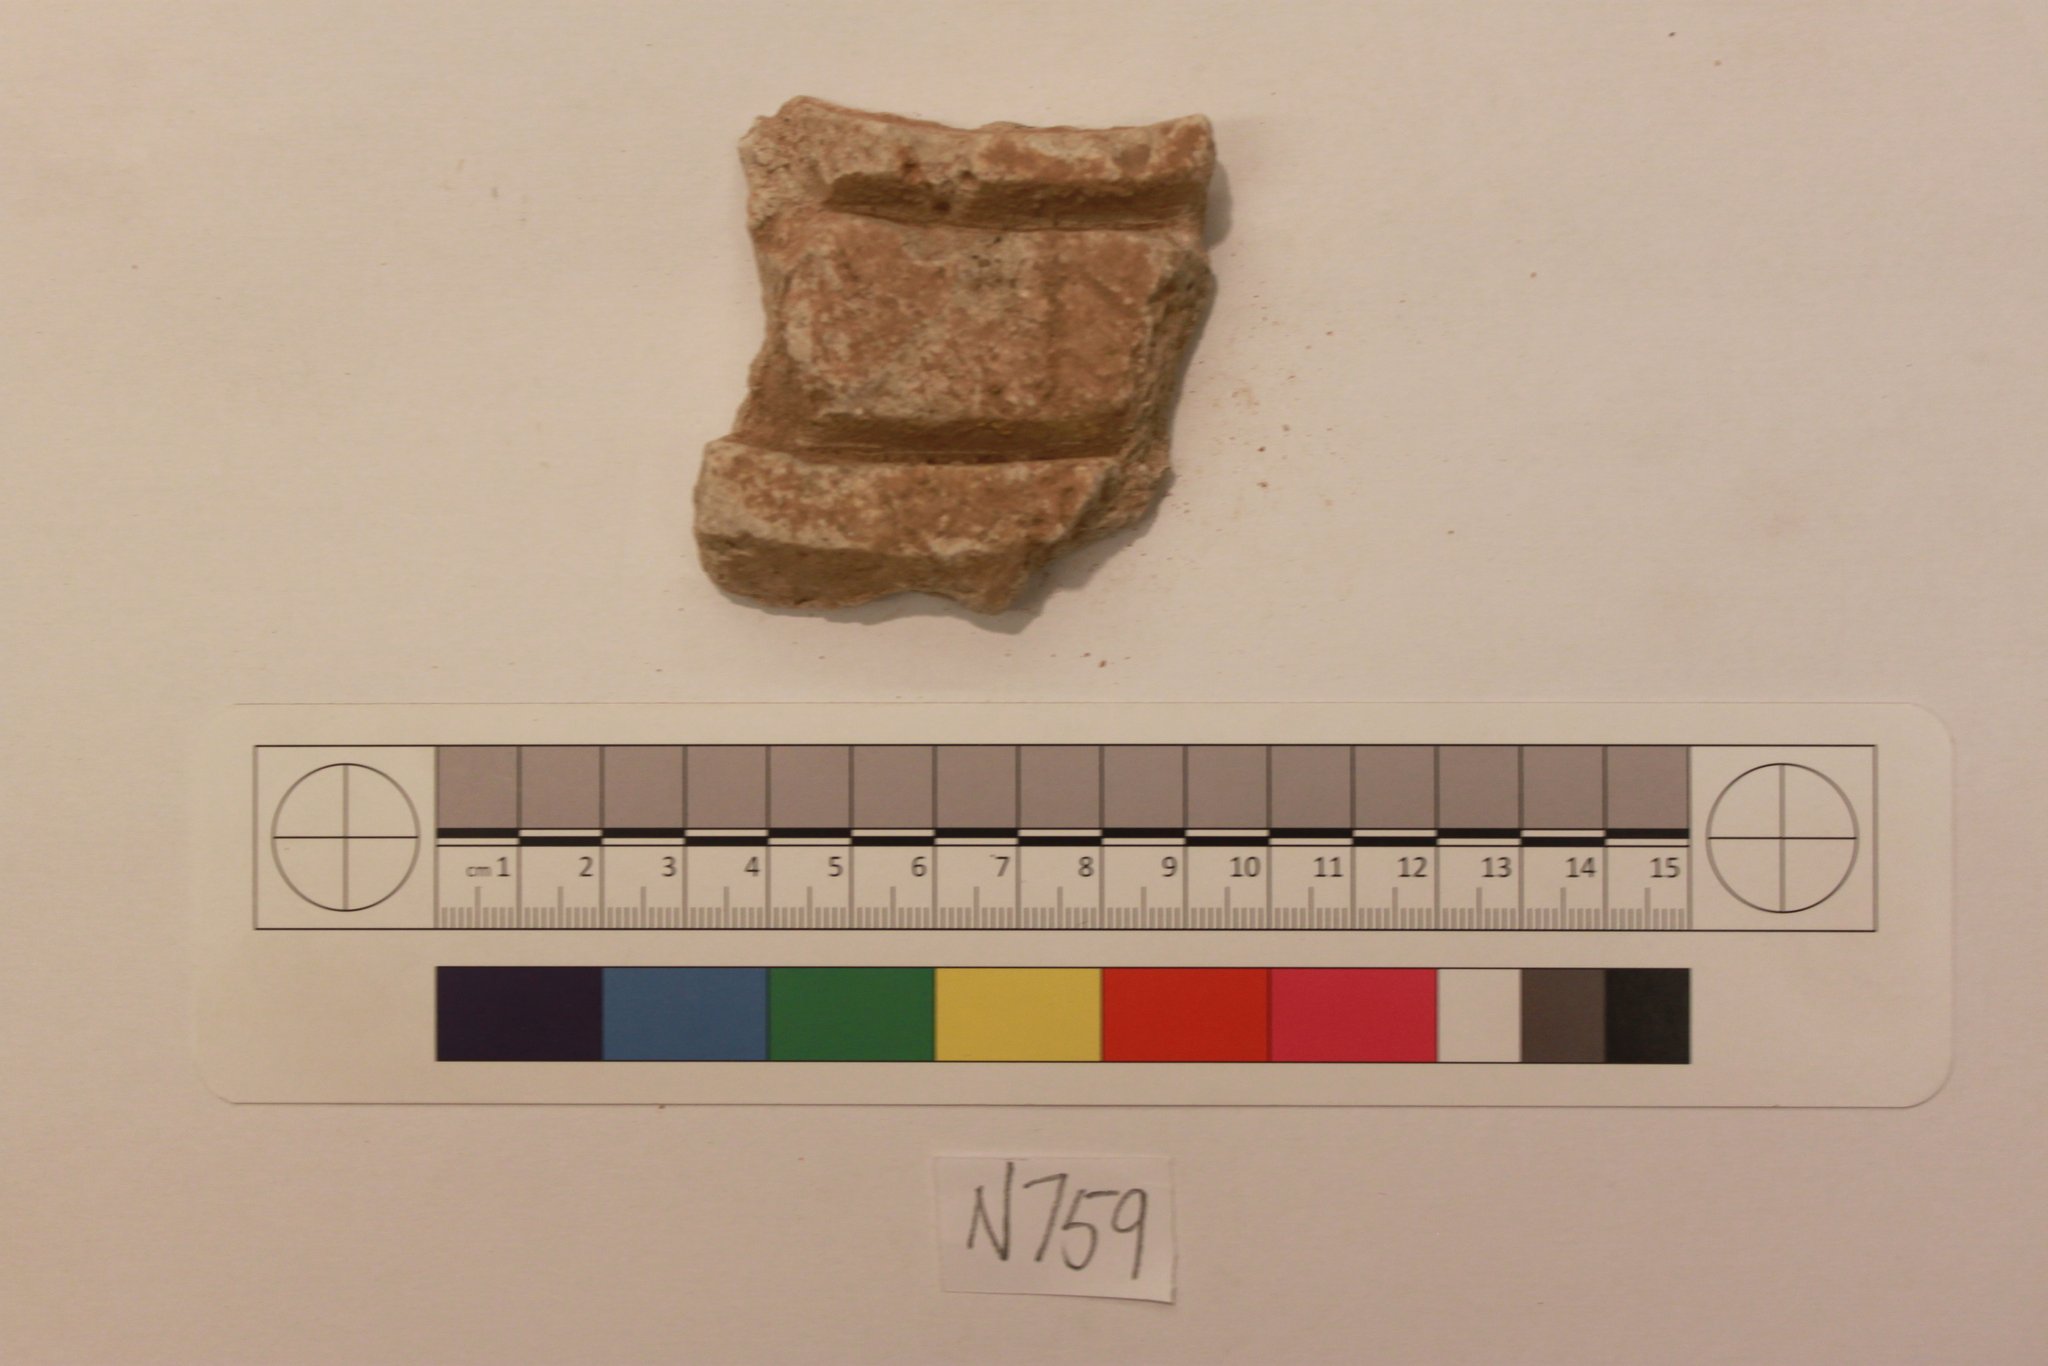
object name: fragment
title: Stucco Fragment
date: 701-1200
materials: plaster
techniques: carving, painting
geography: iran